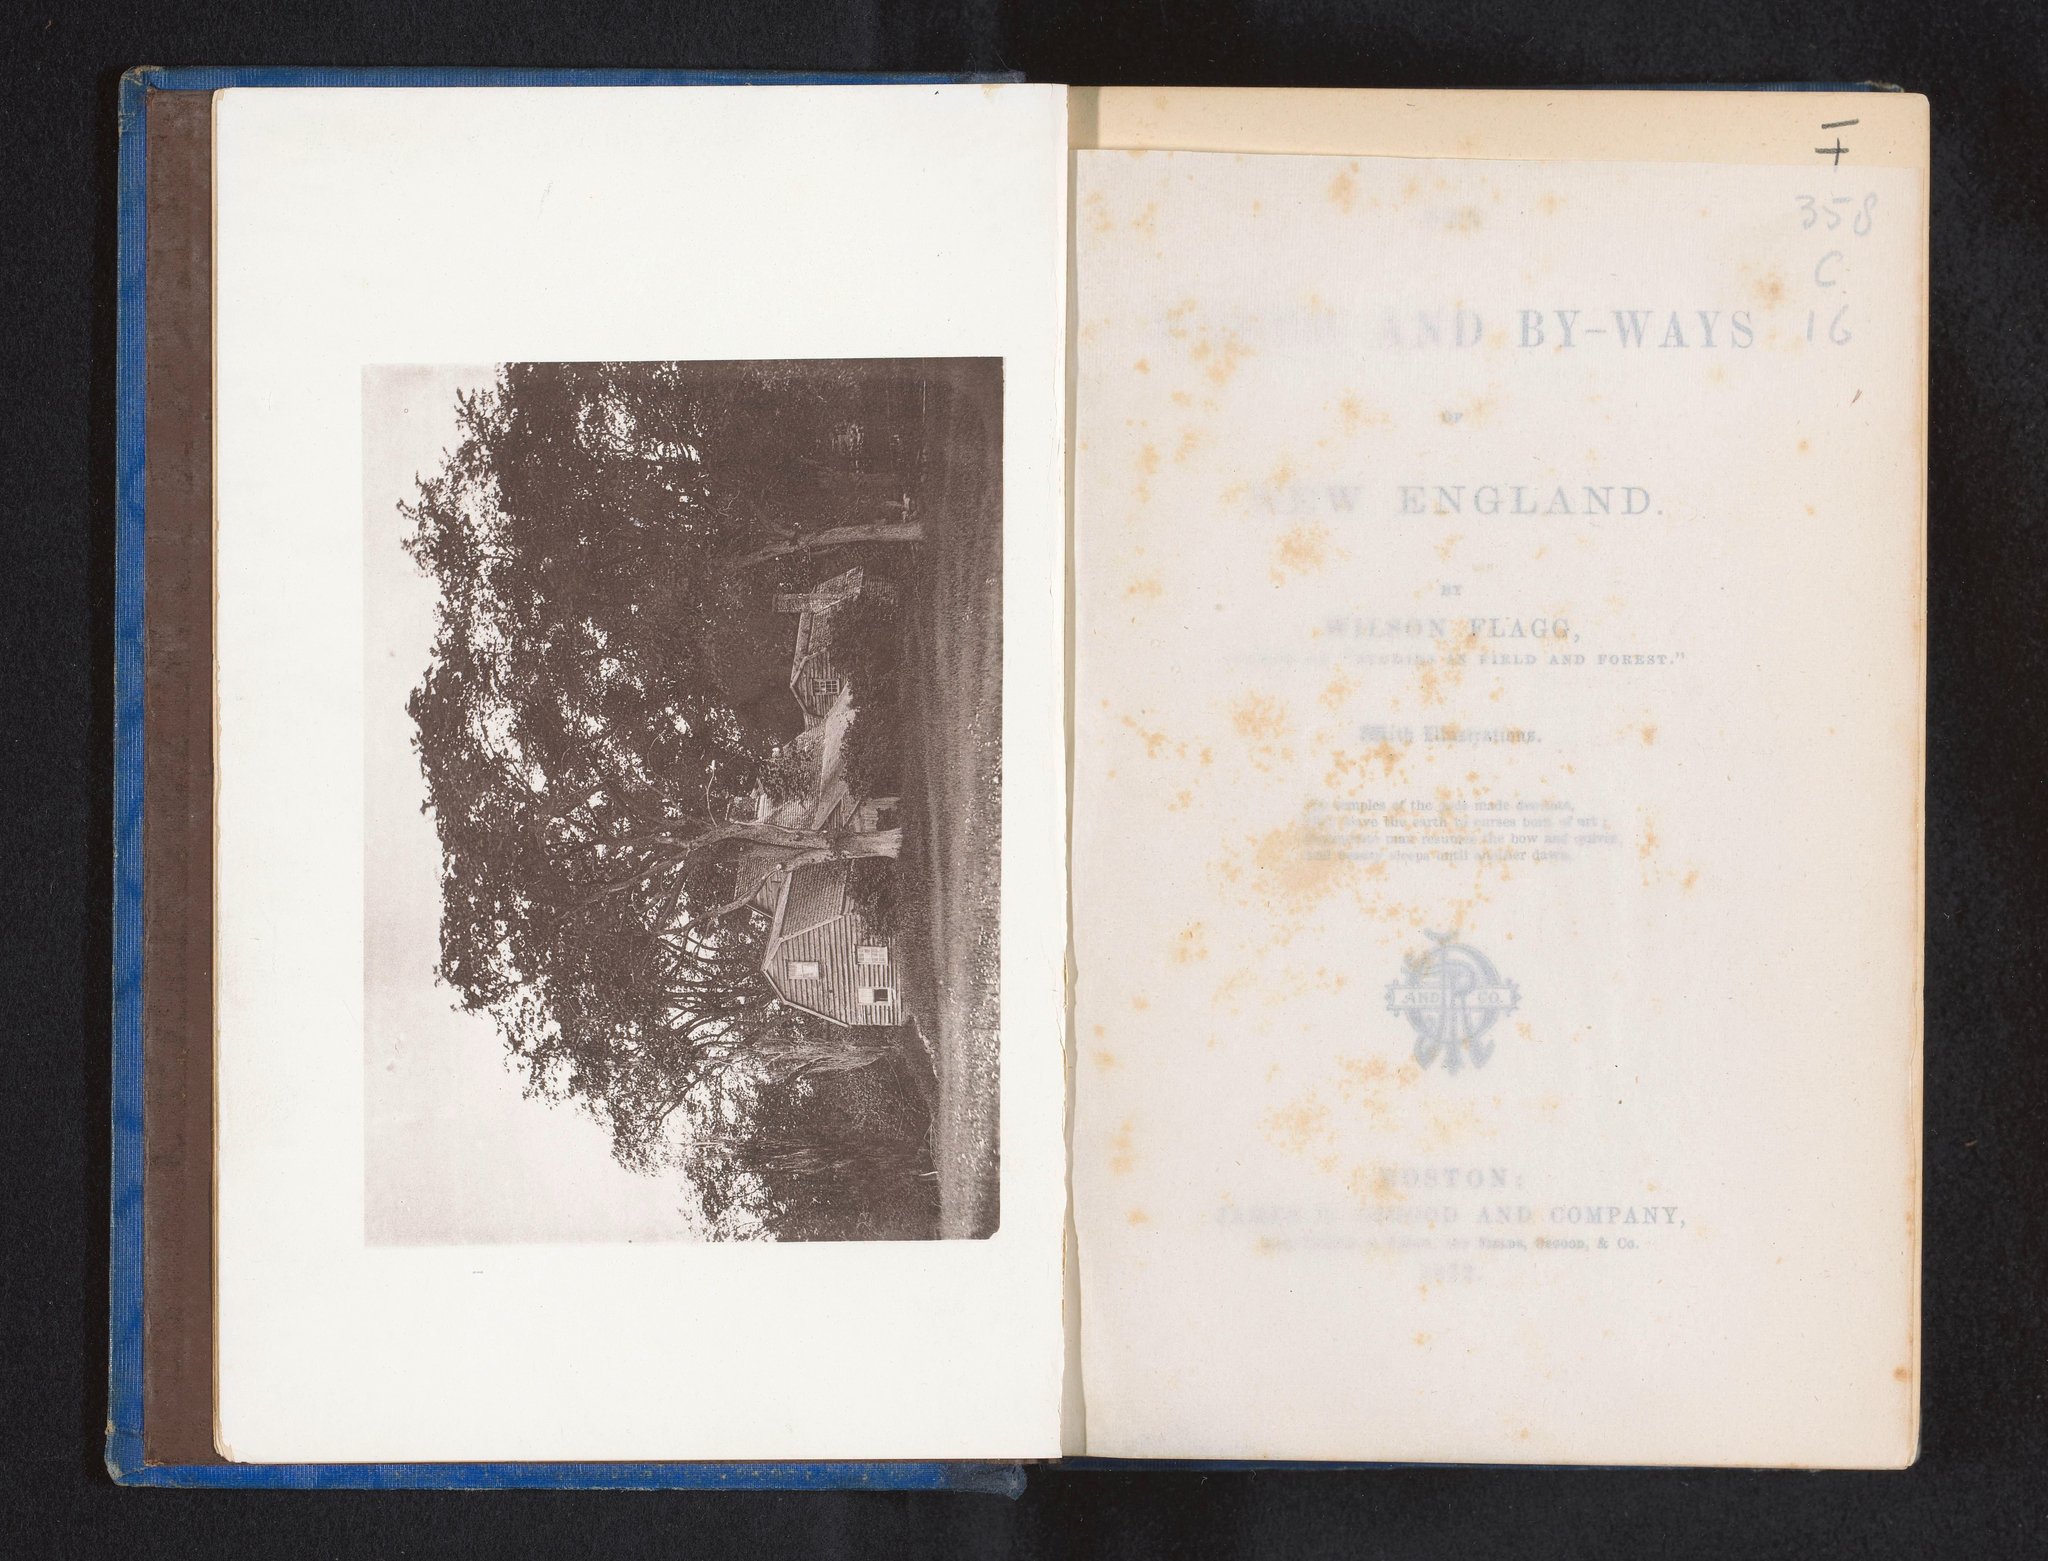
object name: photomechanical print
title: Gezicht op Fairbanks House te Dedham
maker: Anonymous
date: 1872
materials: paper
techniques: photograph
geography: dedham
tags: trees, façade (of house or building)